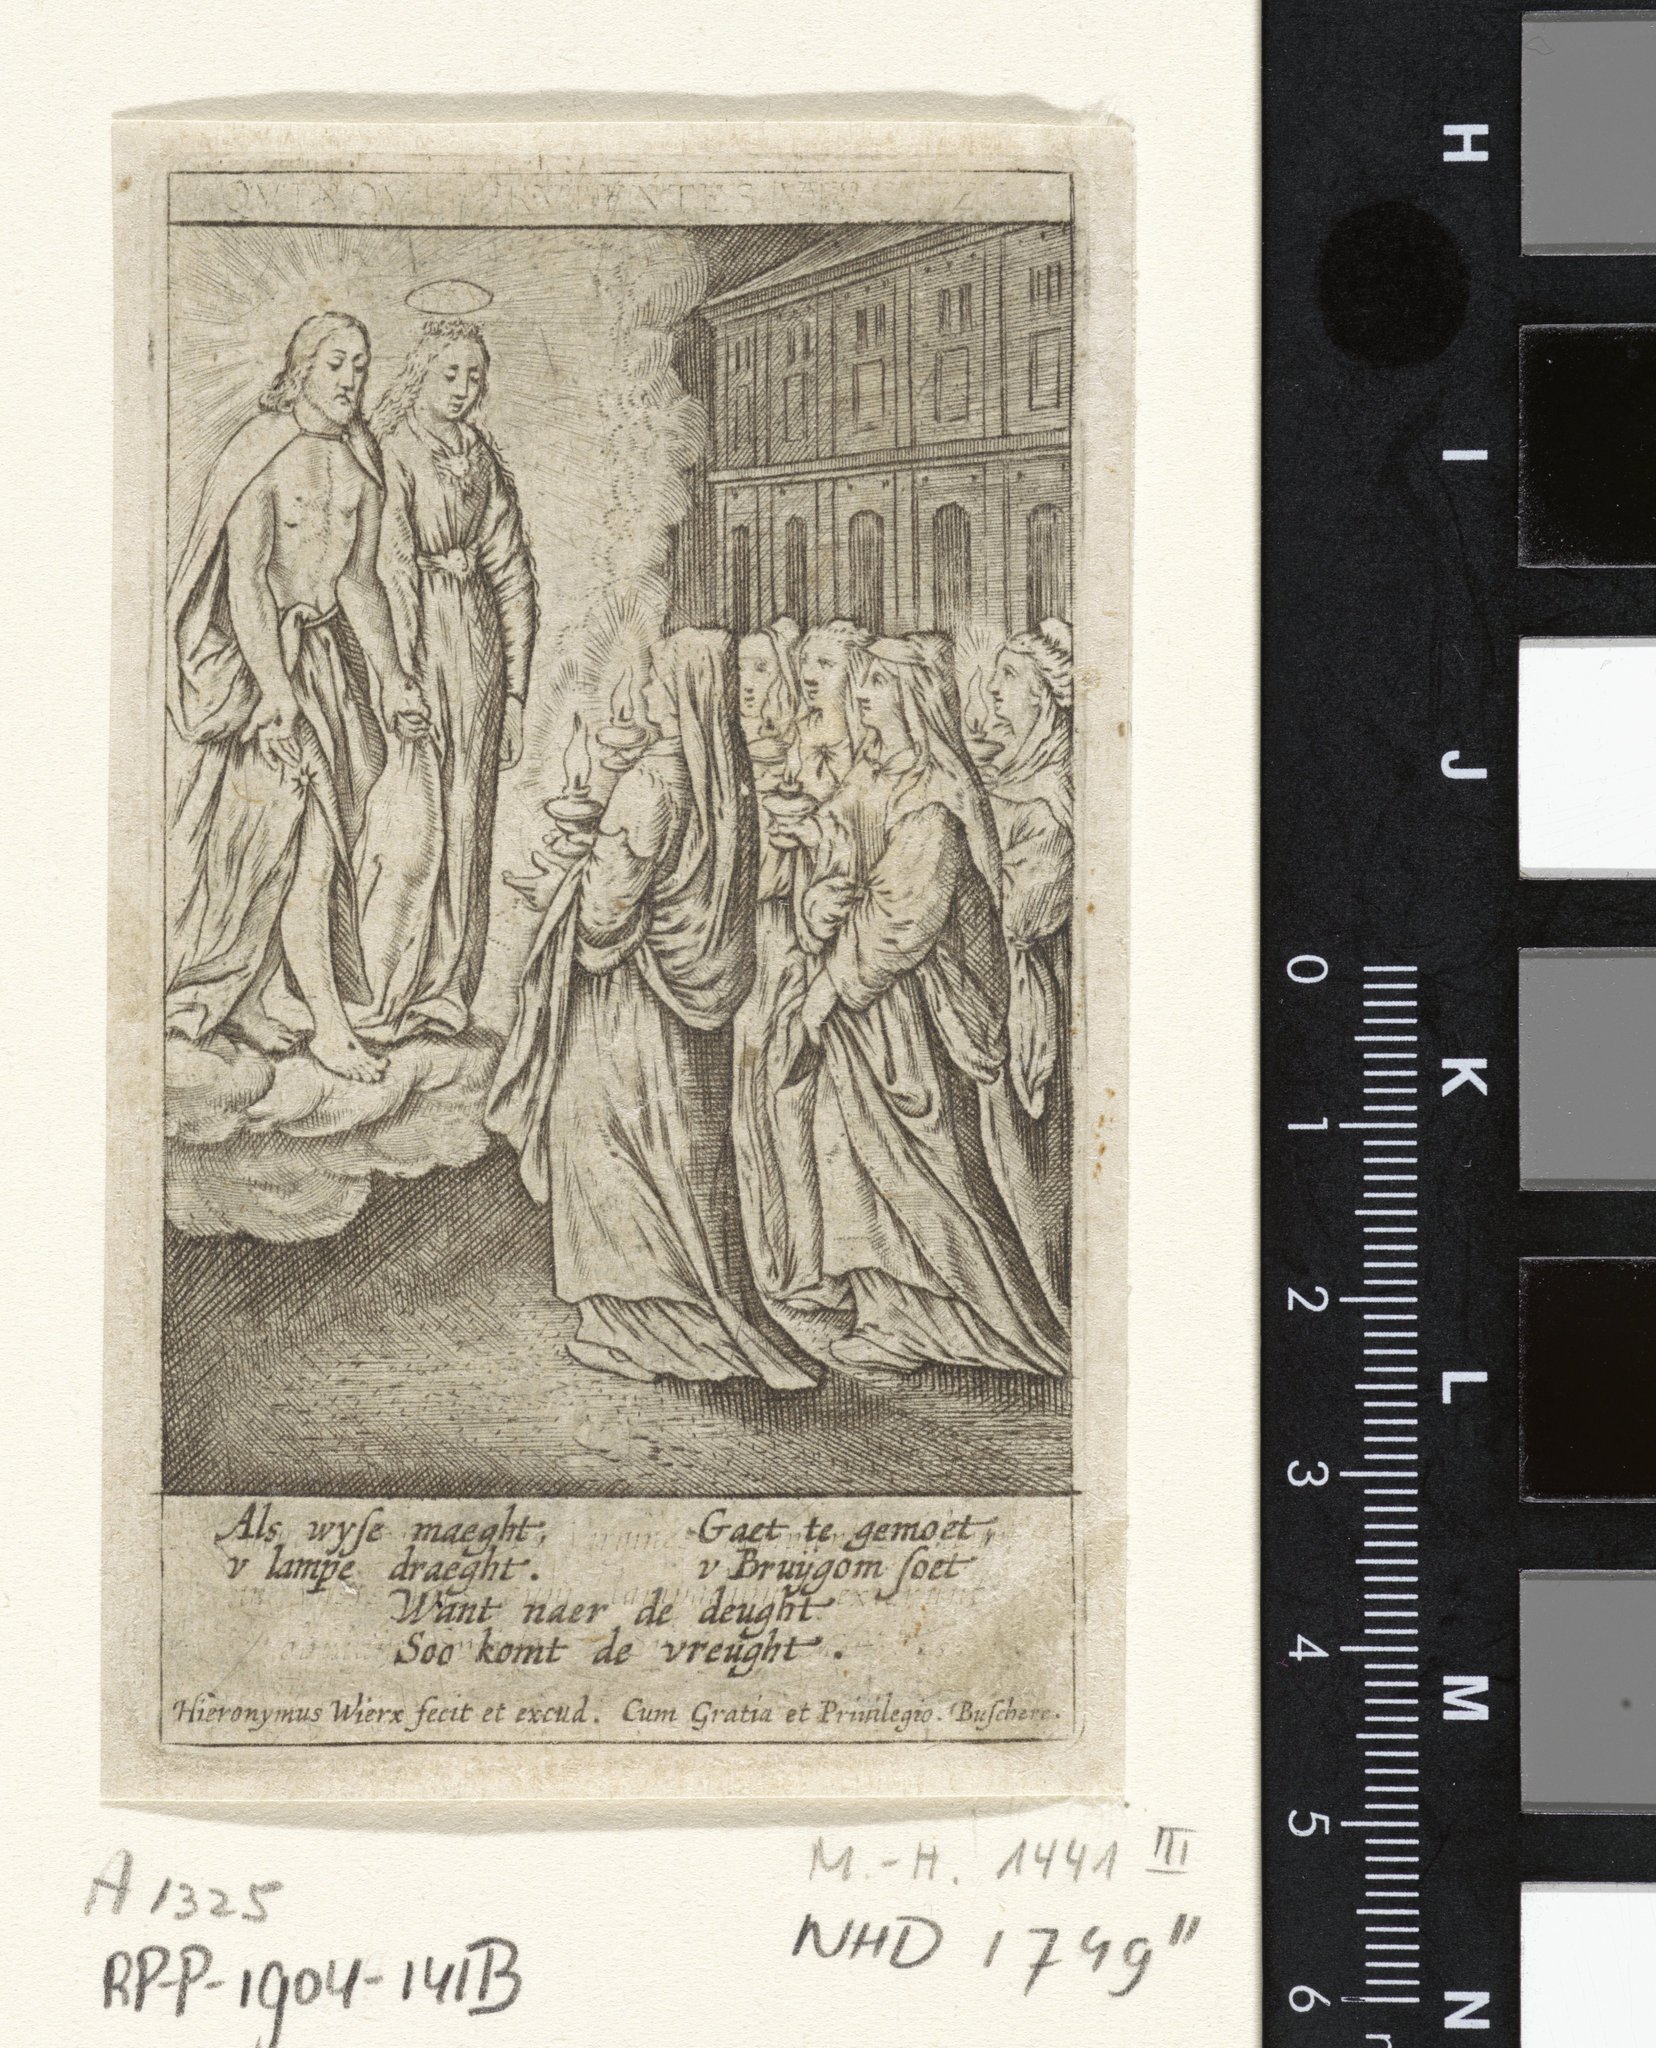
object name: print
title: Specvlvm Virginitatis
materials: paper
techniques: engraving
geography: antwerp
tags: representation of wise virgin(s), adult christ with mary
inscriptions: collector's mark: Lugt 2228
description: Christus en Maria verschijnen aan de vijf wijze maagden. De maagden hebben allen hun olielamp in de hand. In de marge een zesregelig gedicht, in drie kolommen, in het Nederlands.